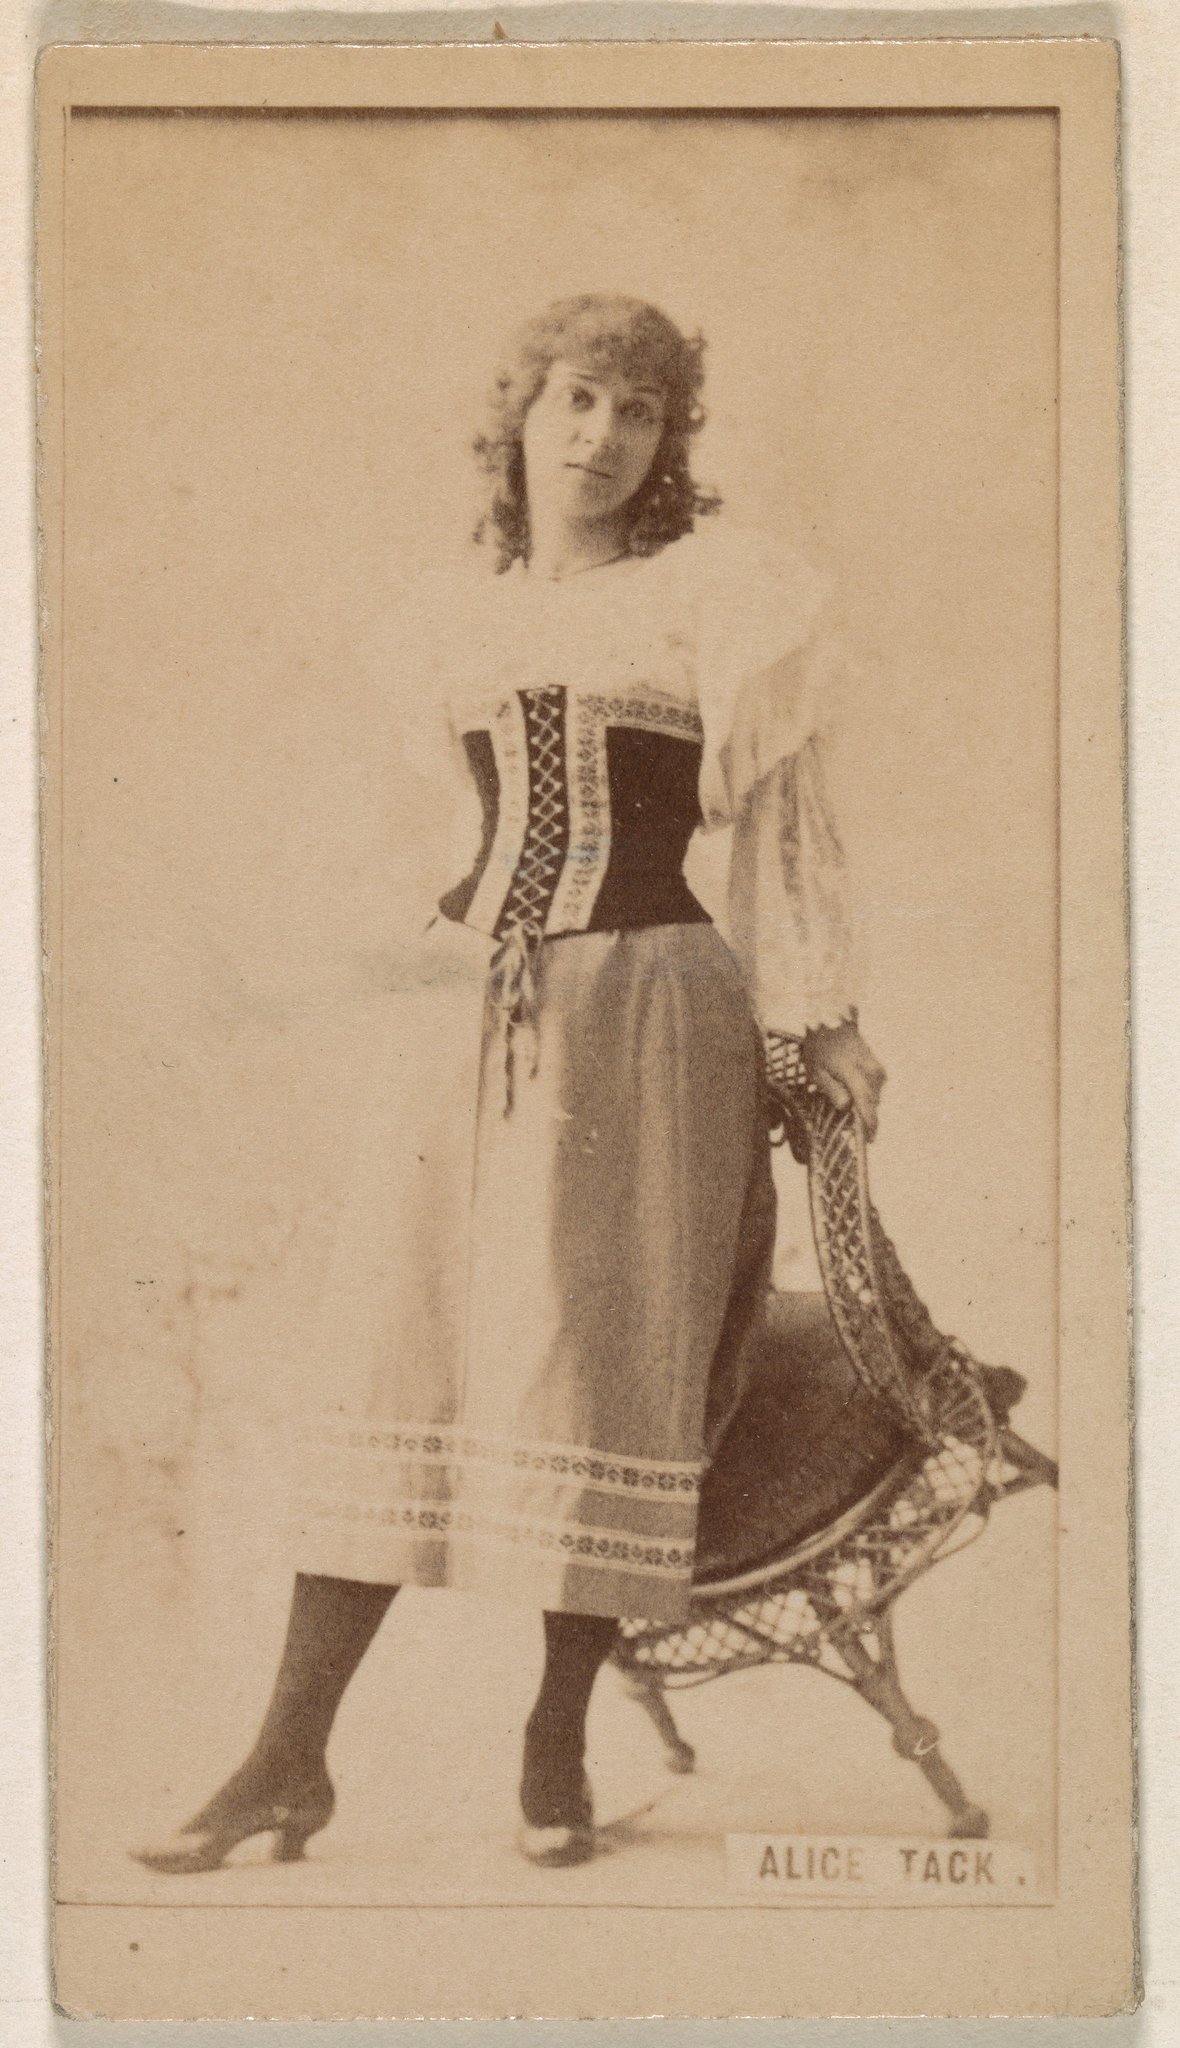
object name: photograph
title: Alice Tack, from the Actresses series (N245) issued by Kinney Brothers to promote Sweet Caporal Cigarettes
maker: kinney brothers tobacco company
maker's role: publisher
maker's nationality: american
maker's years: 1869-2011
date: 1890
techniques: albumen silver print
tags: portraits,women,actresses